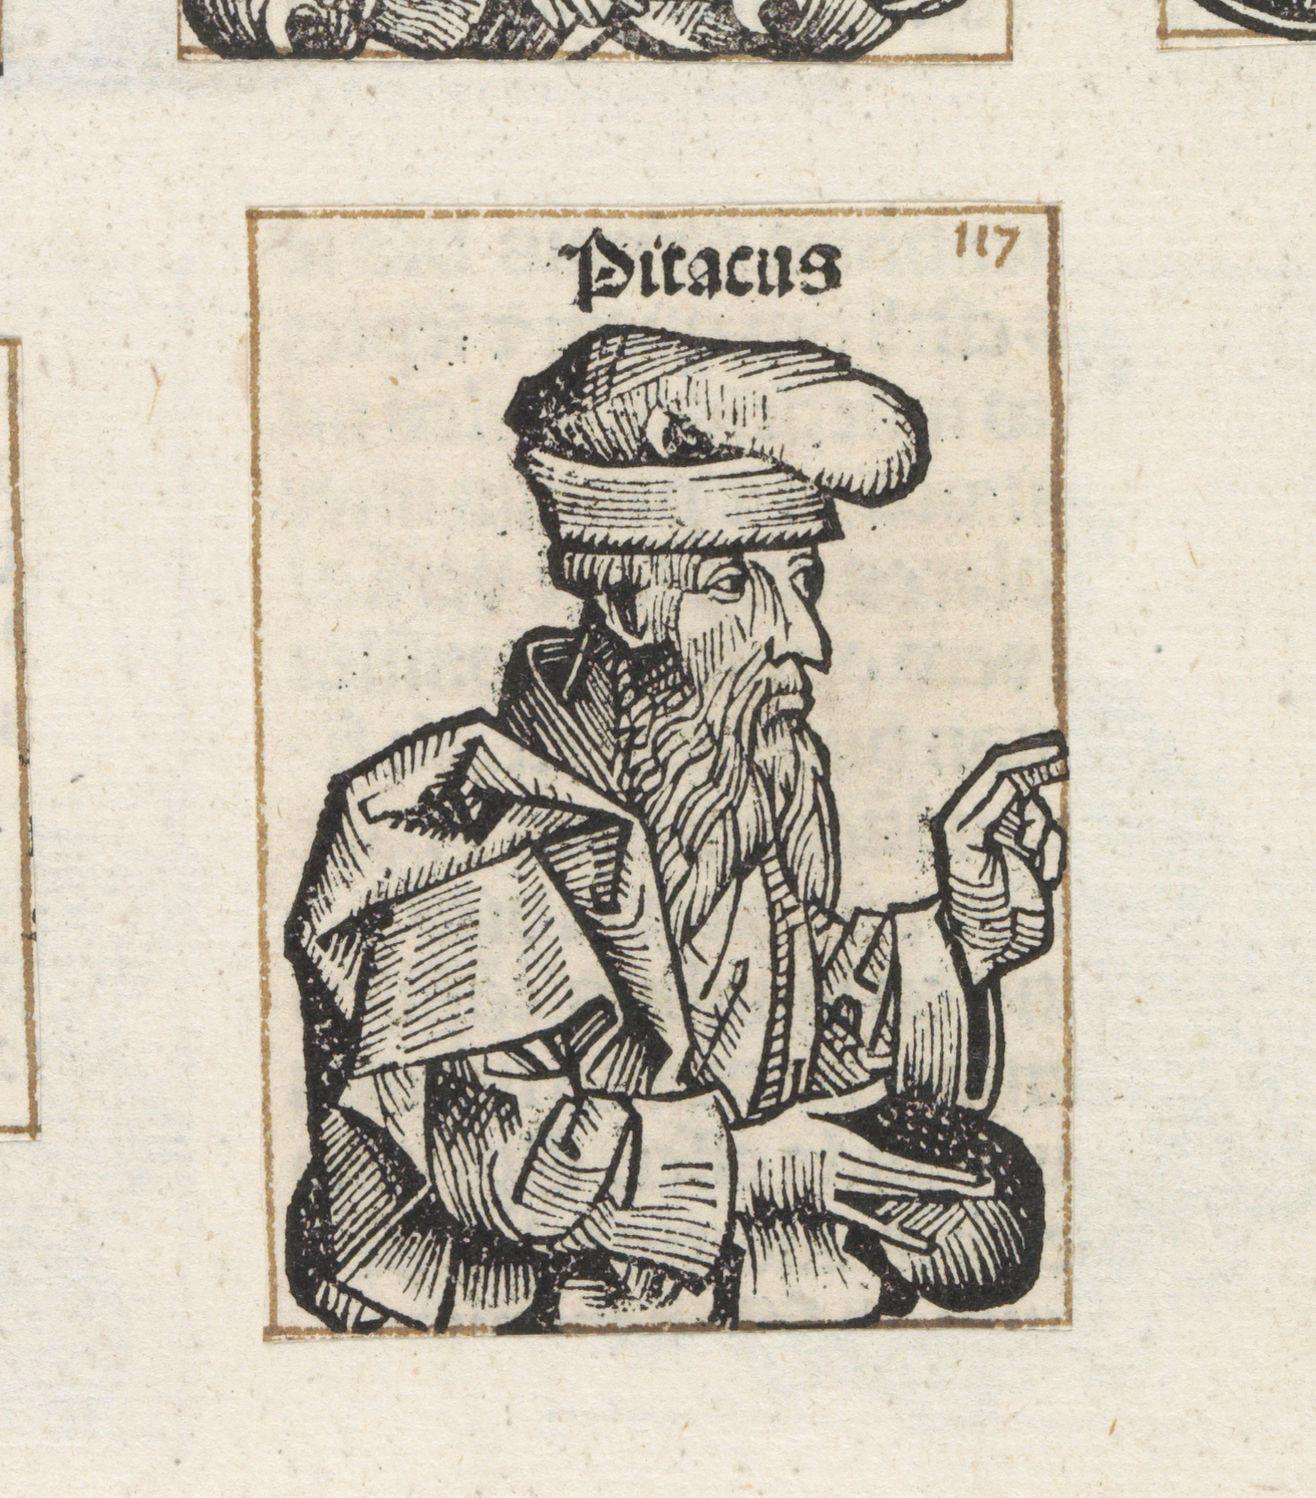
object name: book illustration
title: Liber Chronicarum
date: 1493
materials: paper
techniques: letterpress printing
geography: nuremberg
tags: the seven wise men of greece: bias, chilon, cleobulus, periander (alternatively myson), pittacus, solon, thales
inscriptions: inscription: ‘117’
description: Een bloemkelk met een man in toga met muts op het hoofd, naar rechts gekeerd. Met zijn linkerhand maakt hij een spreekgebaar. De tekst identificeert hem als Pittakos van Mytilene, één van de zeven wijzen van Griekenland. De prent maakt deel uit van een album.